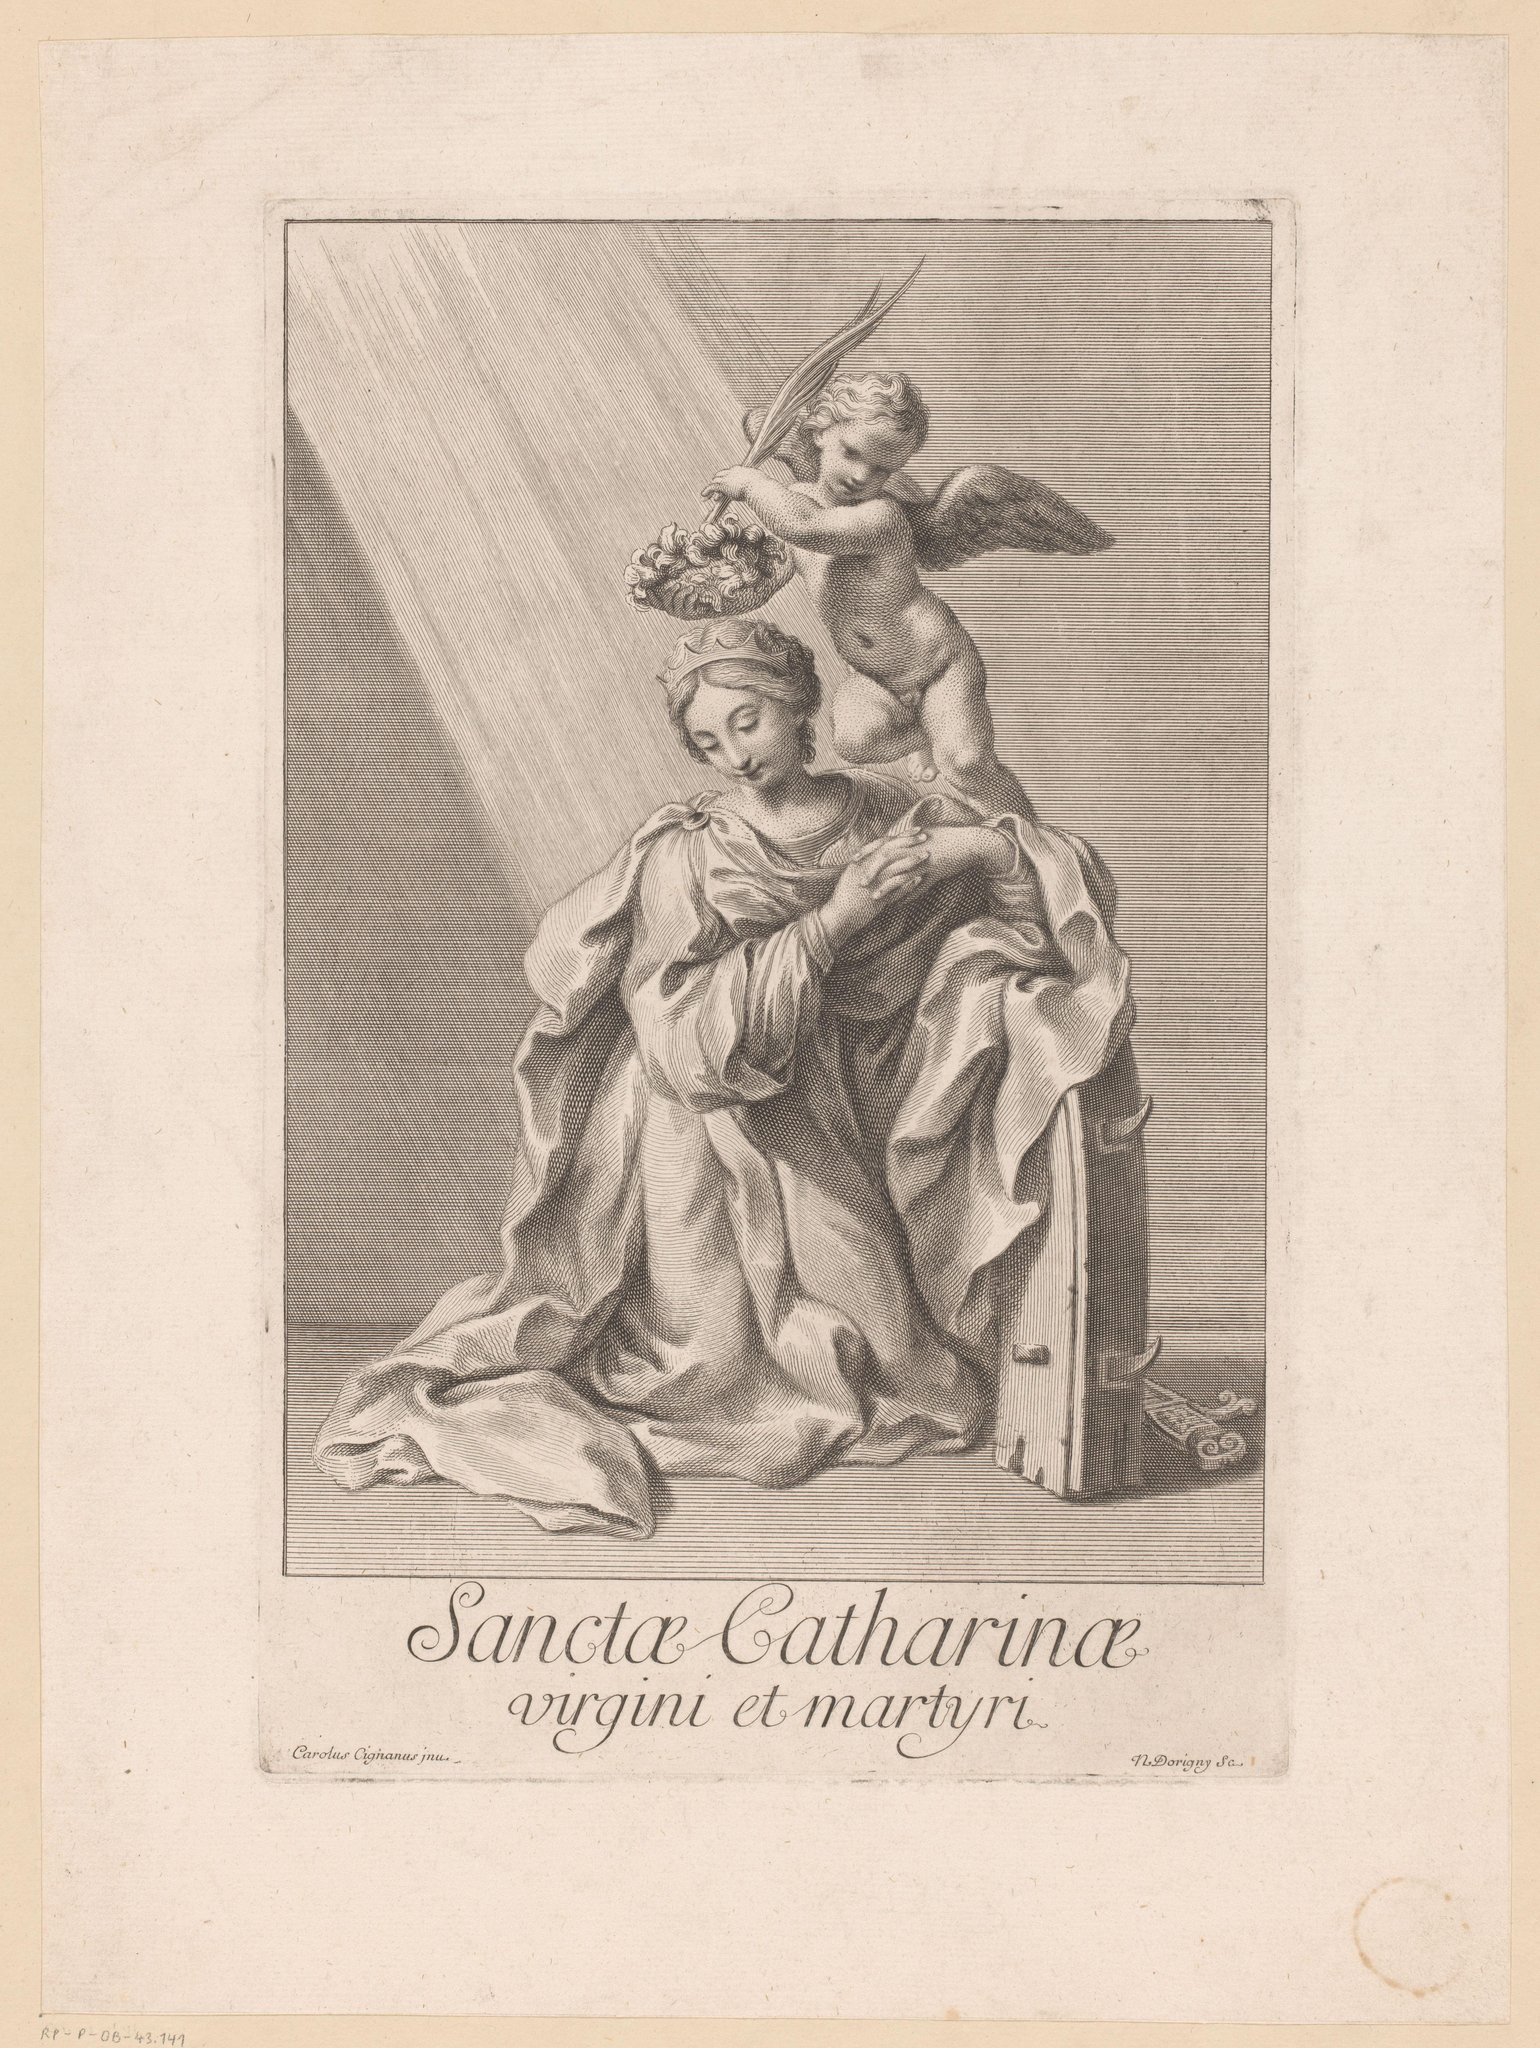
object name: print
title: Sancta Catharina virgini et martyri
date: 1662-1746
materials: paper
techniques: engraving, etching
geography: france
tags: the virgin martyr catherine of alexandria; possible attributes: book, crown, emperor maxentius, palm-branch, ring, sword, wheel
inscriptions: collector's mark: Lugt 240